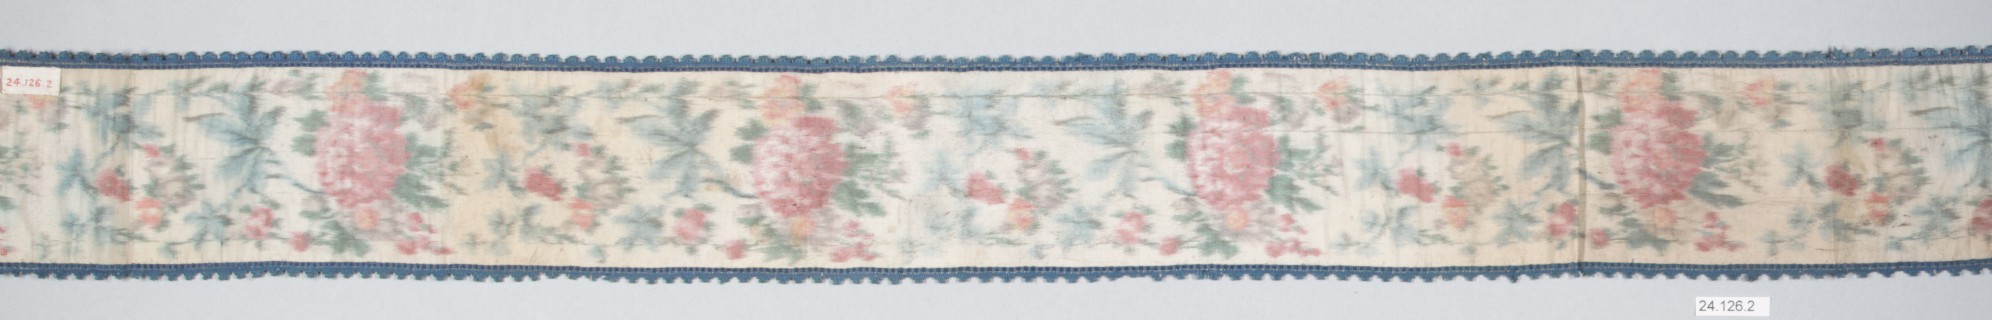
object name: ribbon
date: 1701-1900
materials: silk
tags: flowers